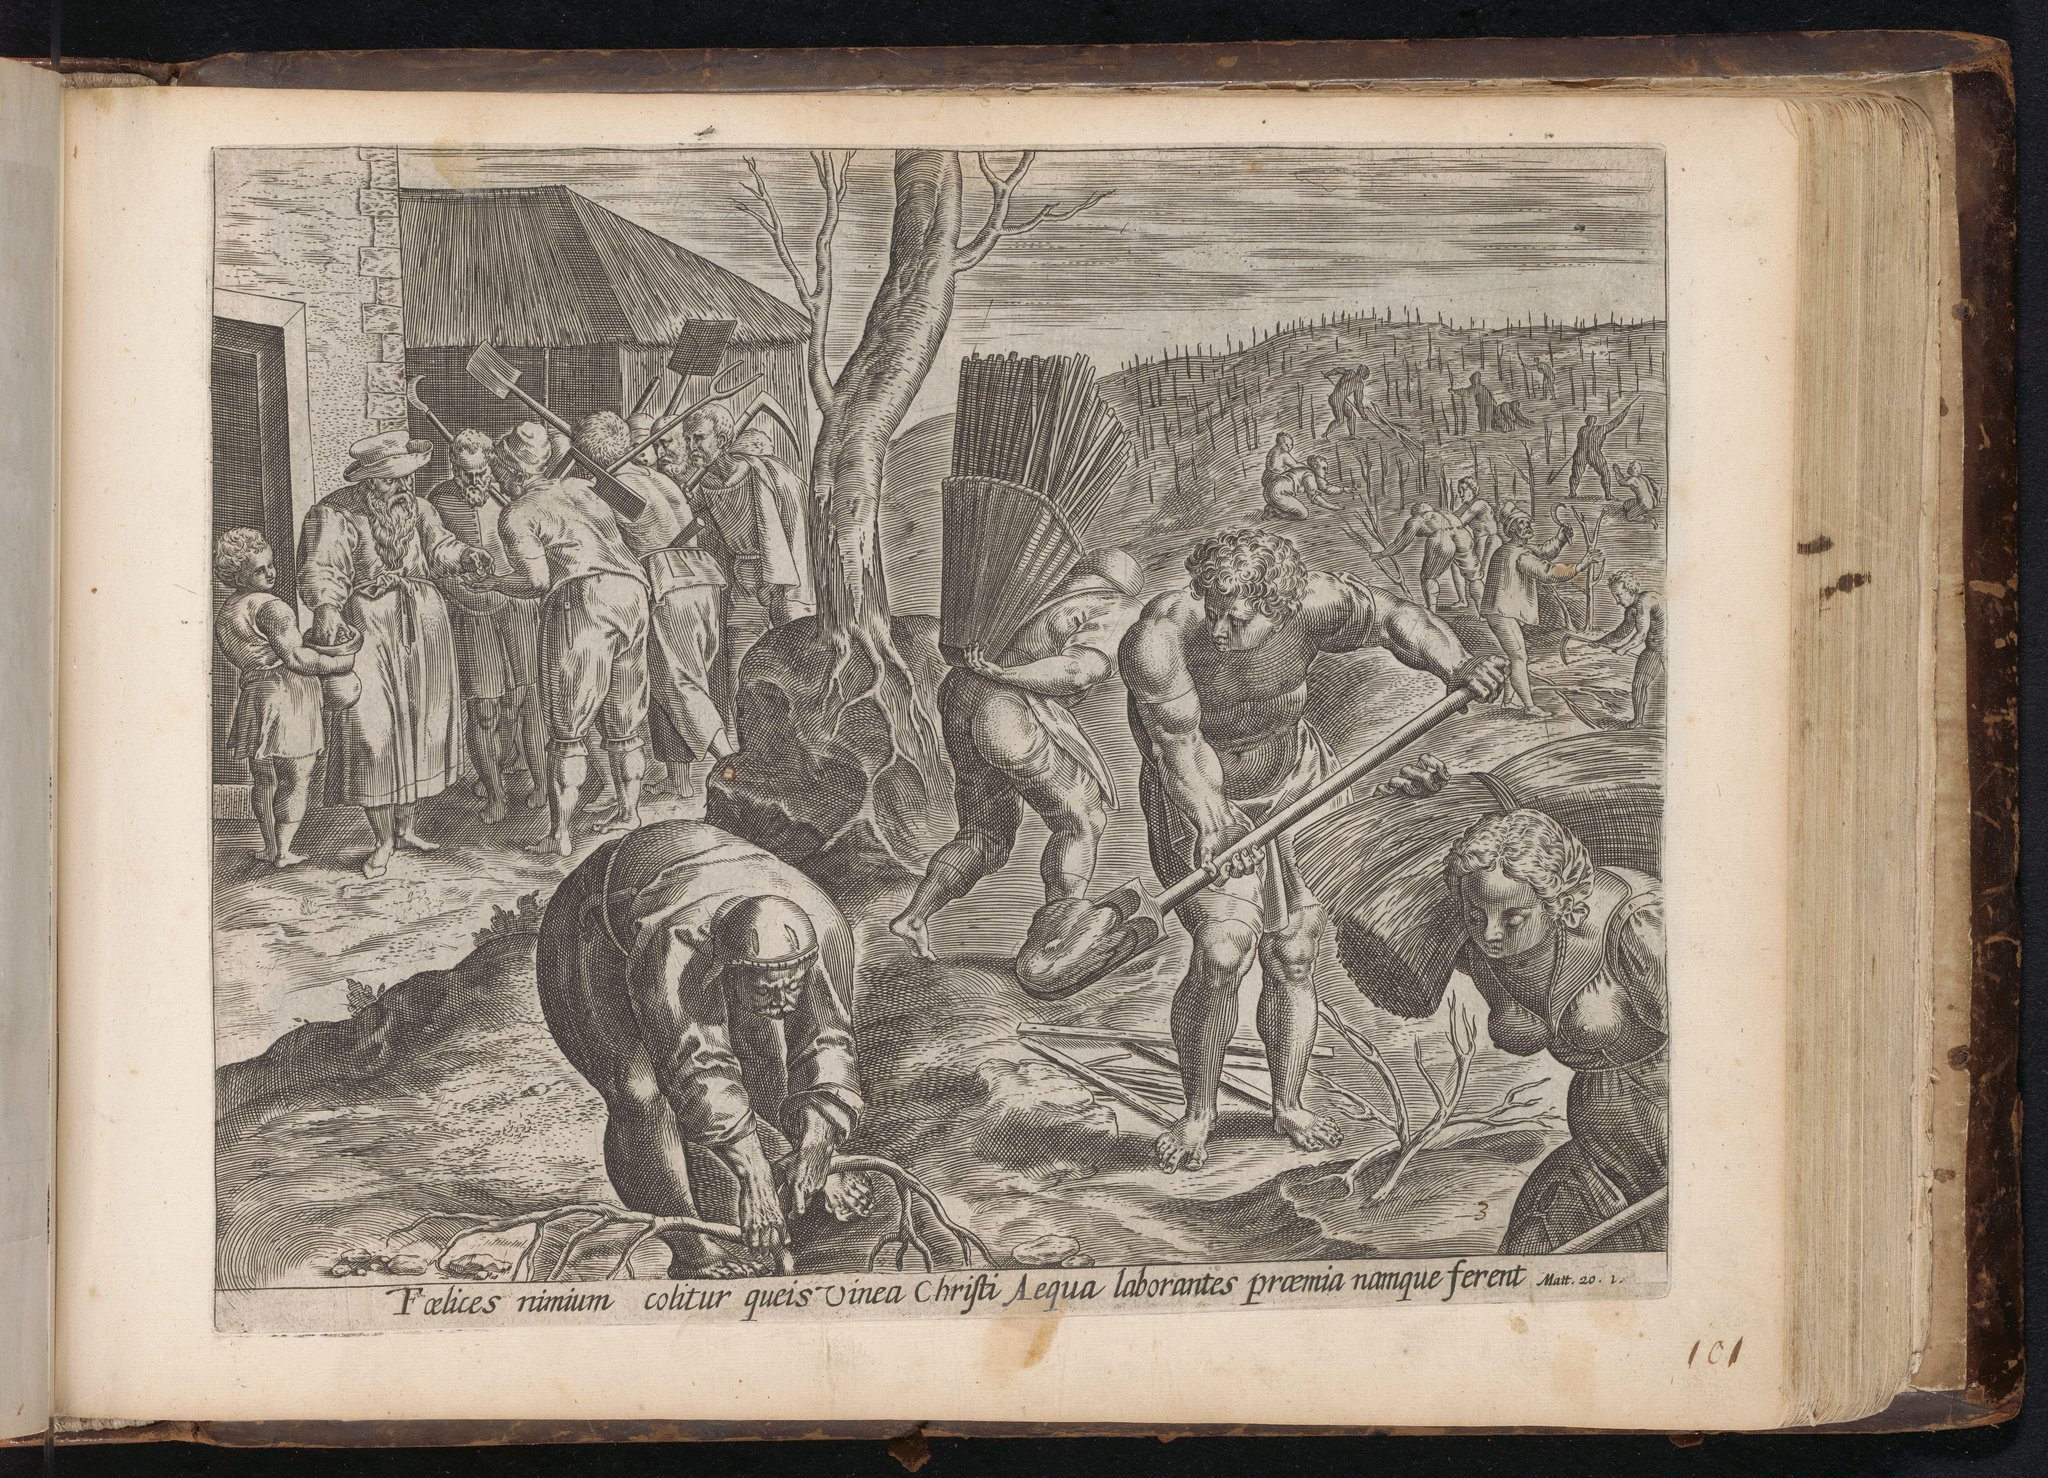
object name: album leaf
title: Gelijkenis van de werkers in de wijngaard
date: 1585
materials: paper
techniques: engraving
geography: amsterdam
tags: the labourers in the vineyard ~ parable of christ (matthew 20:1-16), at the end of the day the lord pays all the labourers equally; those that worked all day object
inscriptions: serial number: ‘3’, number: ‘101’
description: Dagloners werken in een wijngaard waar zij spitten en hout verwijderen. Links krijgen de dagloners hun salaris uitbetaald. Degenen die pas later op de dag zijn komen werken krijgen evenveel als degenen die vroeg op de dag zijn begonnen. Onder de voorstelling een verwijzing in het Latijn naar de Bijbeltekst in Mat. 20:1. Deze prent maakt deel uit van een album.